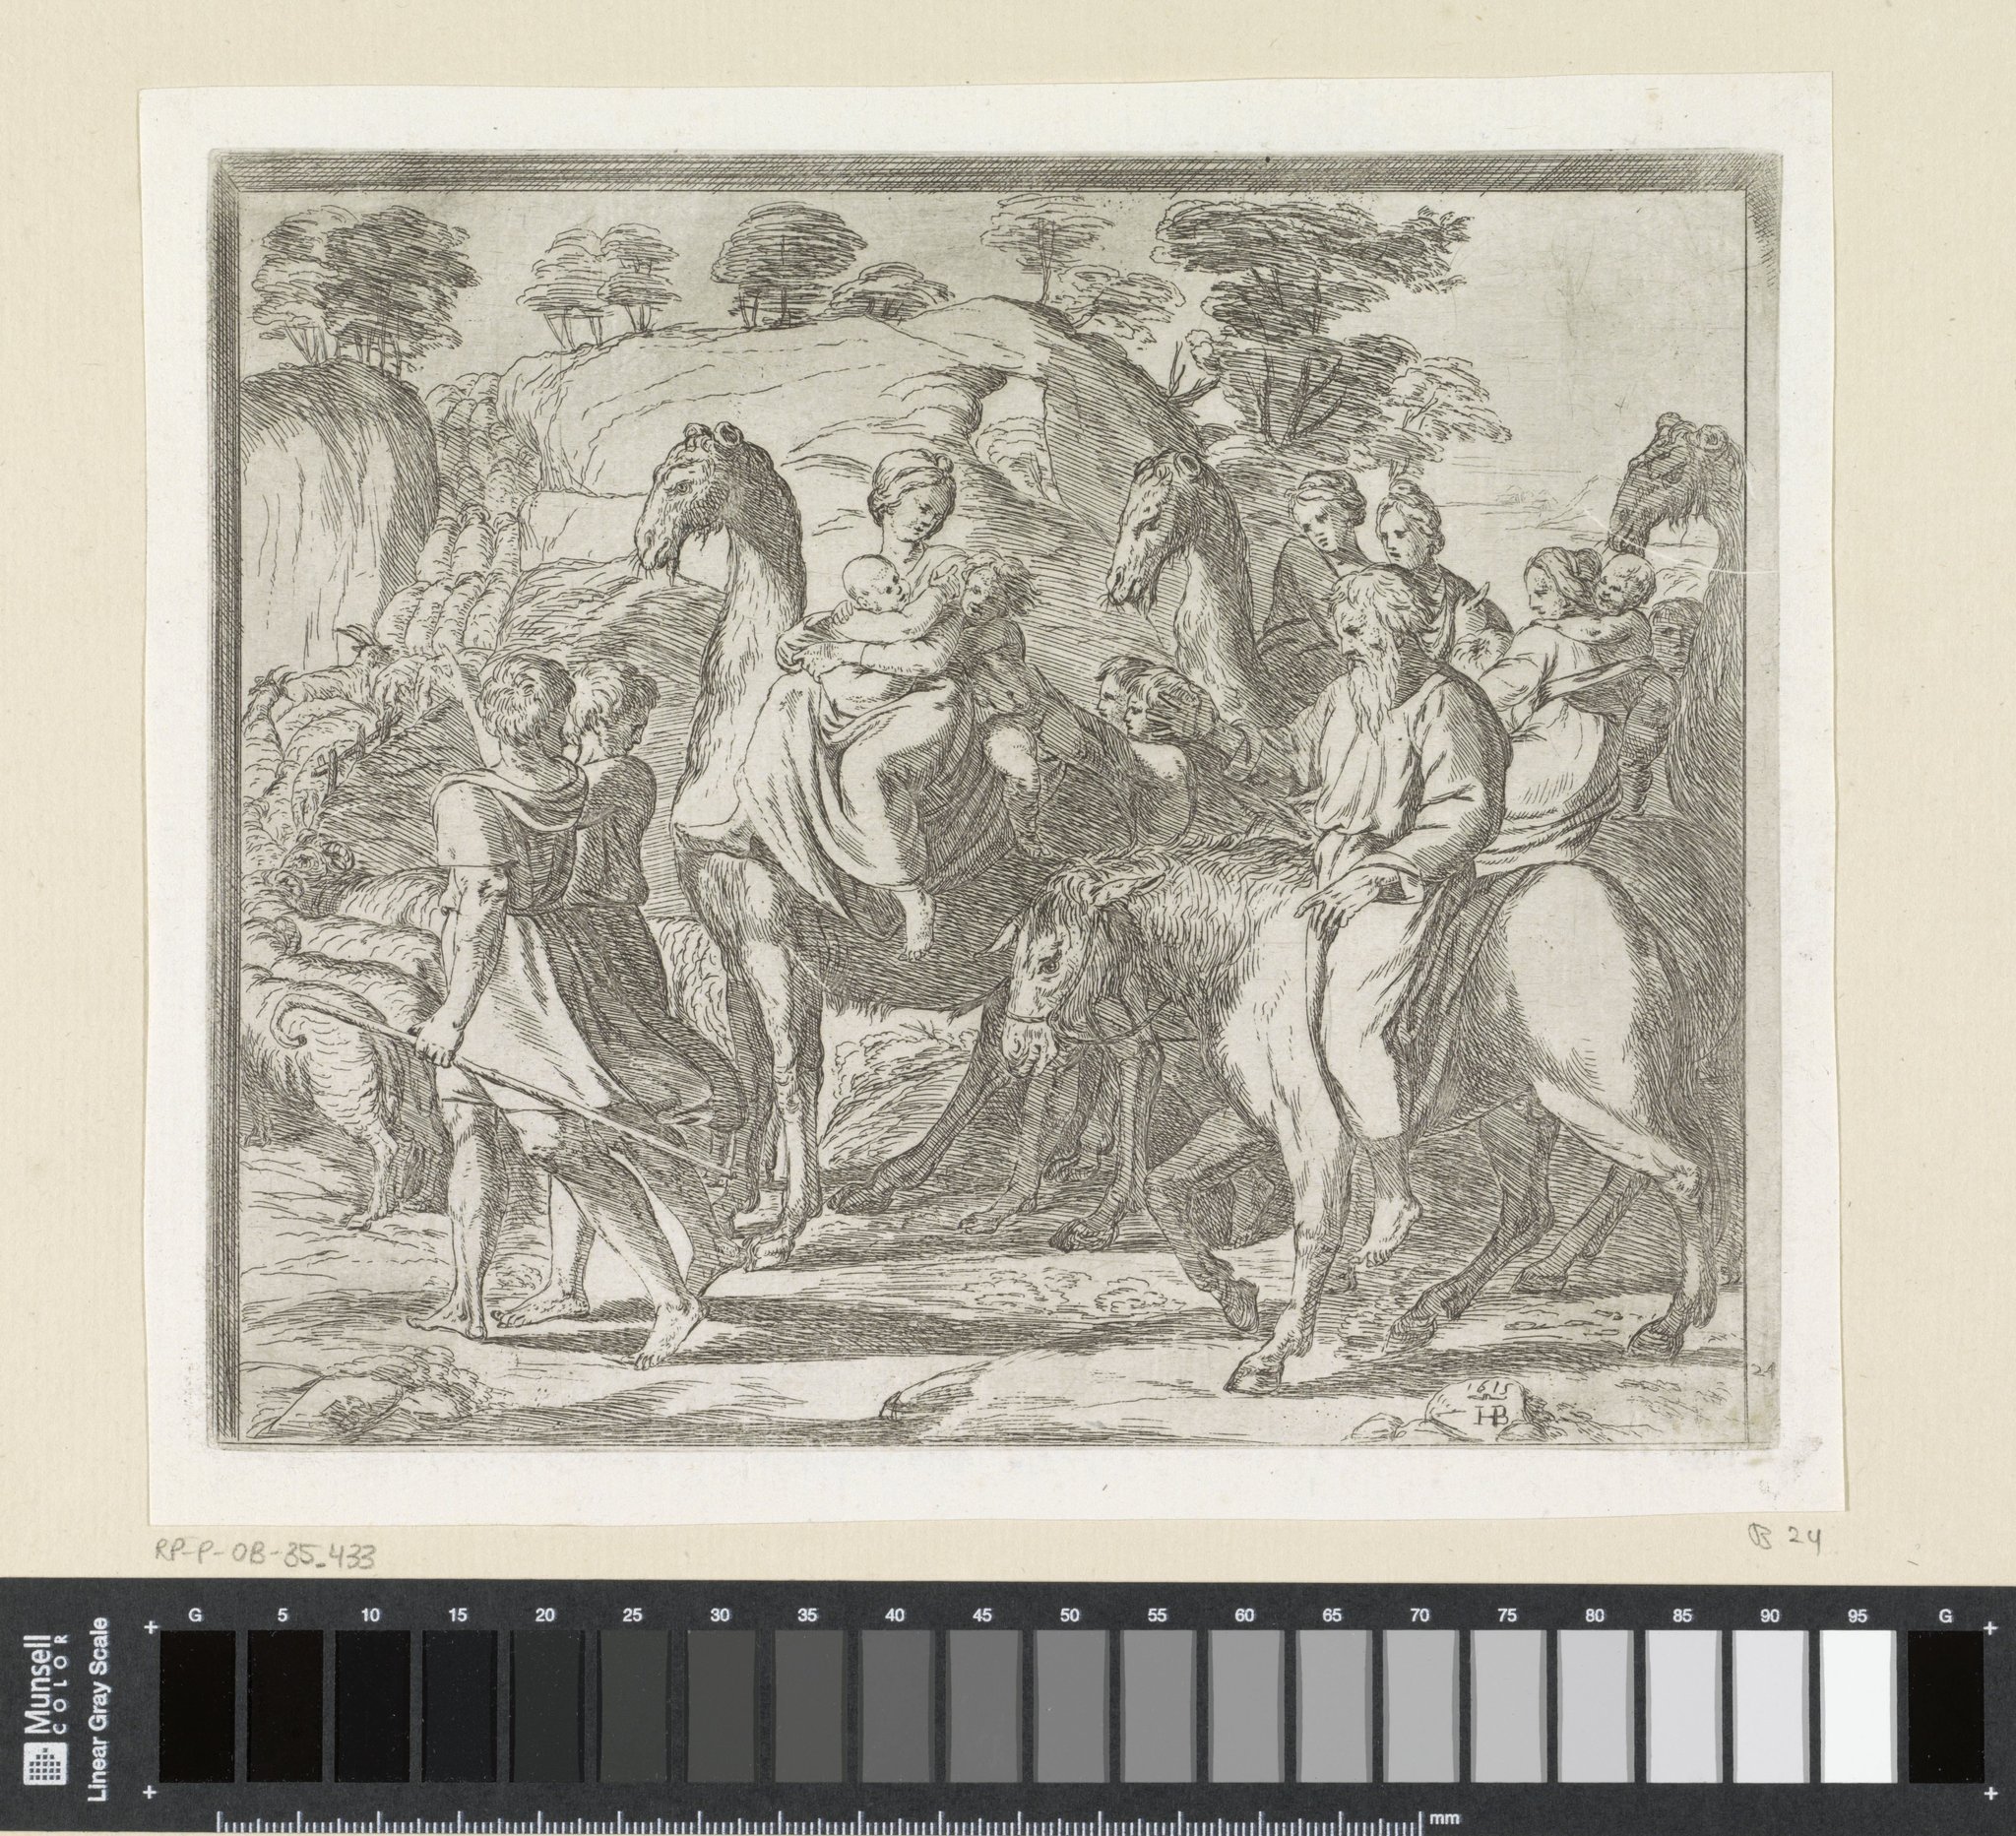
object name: print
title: Schilderingen in de Loggia van Rafaël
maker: orazio borgianni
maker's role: print maker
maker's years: 1578-1616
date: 1615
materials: paper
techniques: etching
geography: vatican city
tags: jacob on the way to canaan with his family, his flocks, camels and all his possessions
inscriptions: collector's mark: Lugt 2165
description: Prent uit een reeks van 52 prenten naar schilderingen in de Loggia van Rafaël in het Vaticaan.